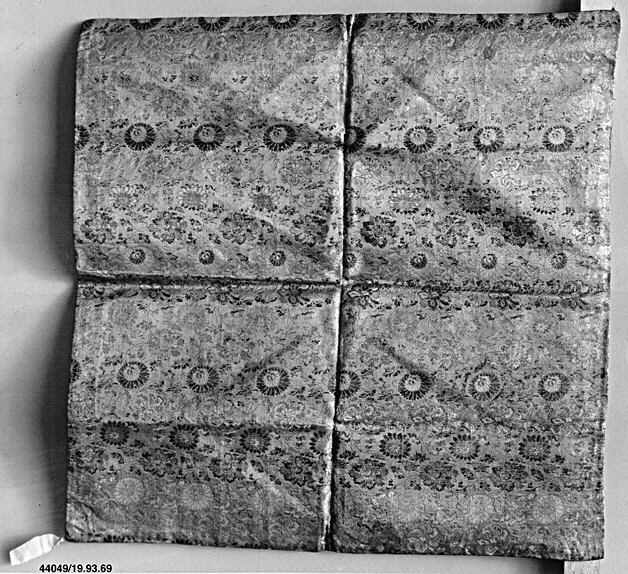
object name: altar cloth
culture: japanese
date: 1716-1736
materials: metal thread, silk